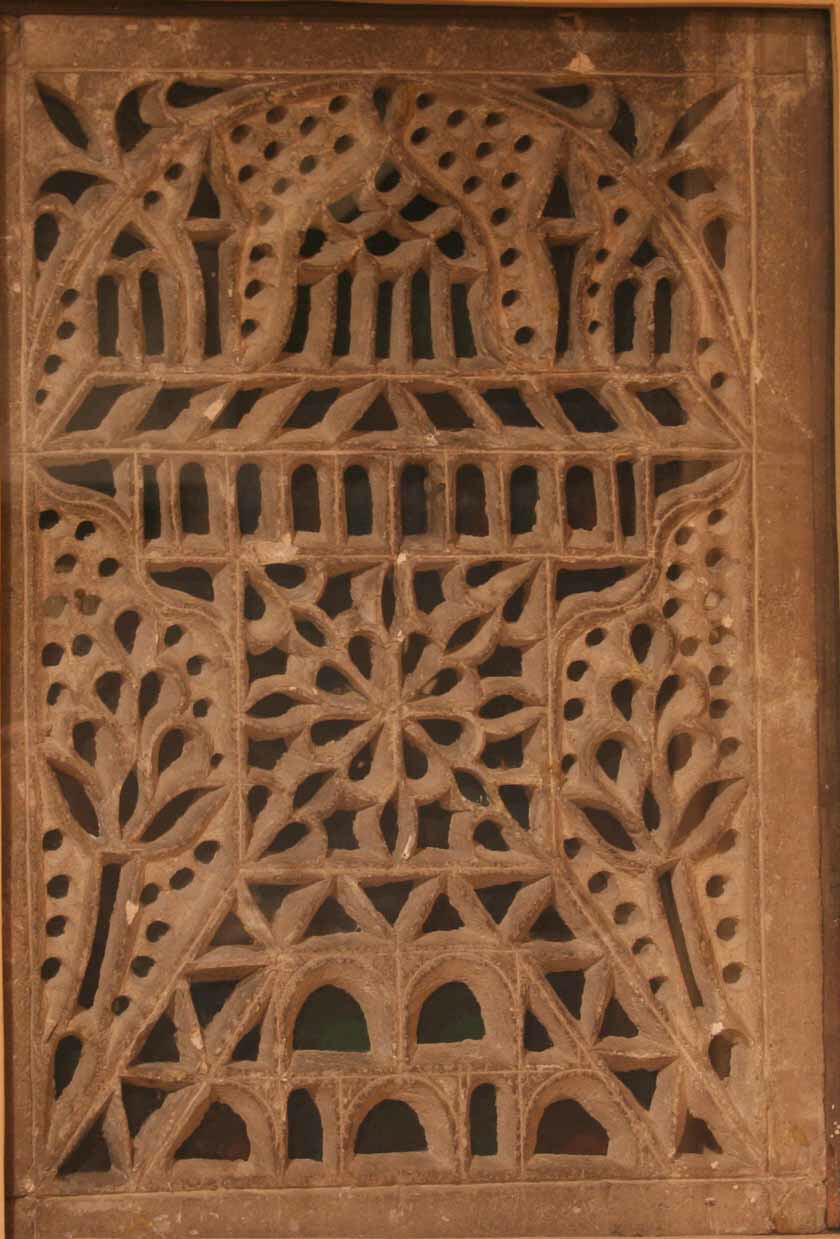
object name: window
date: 1701-1800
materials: gypsum, glass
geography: egypt or syria